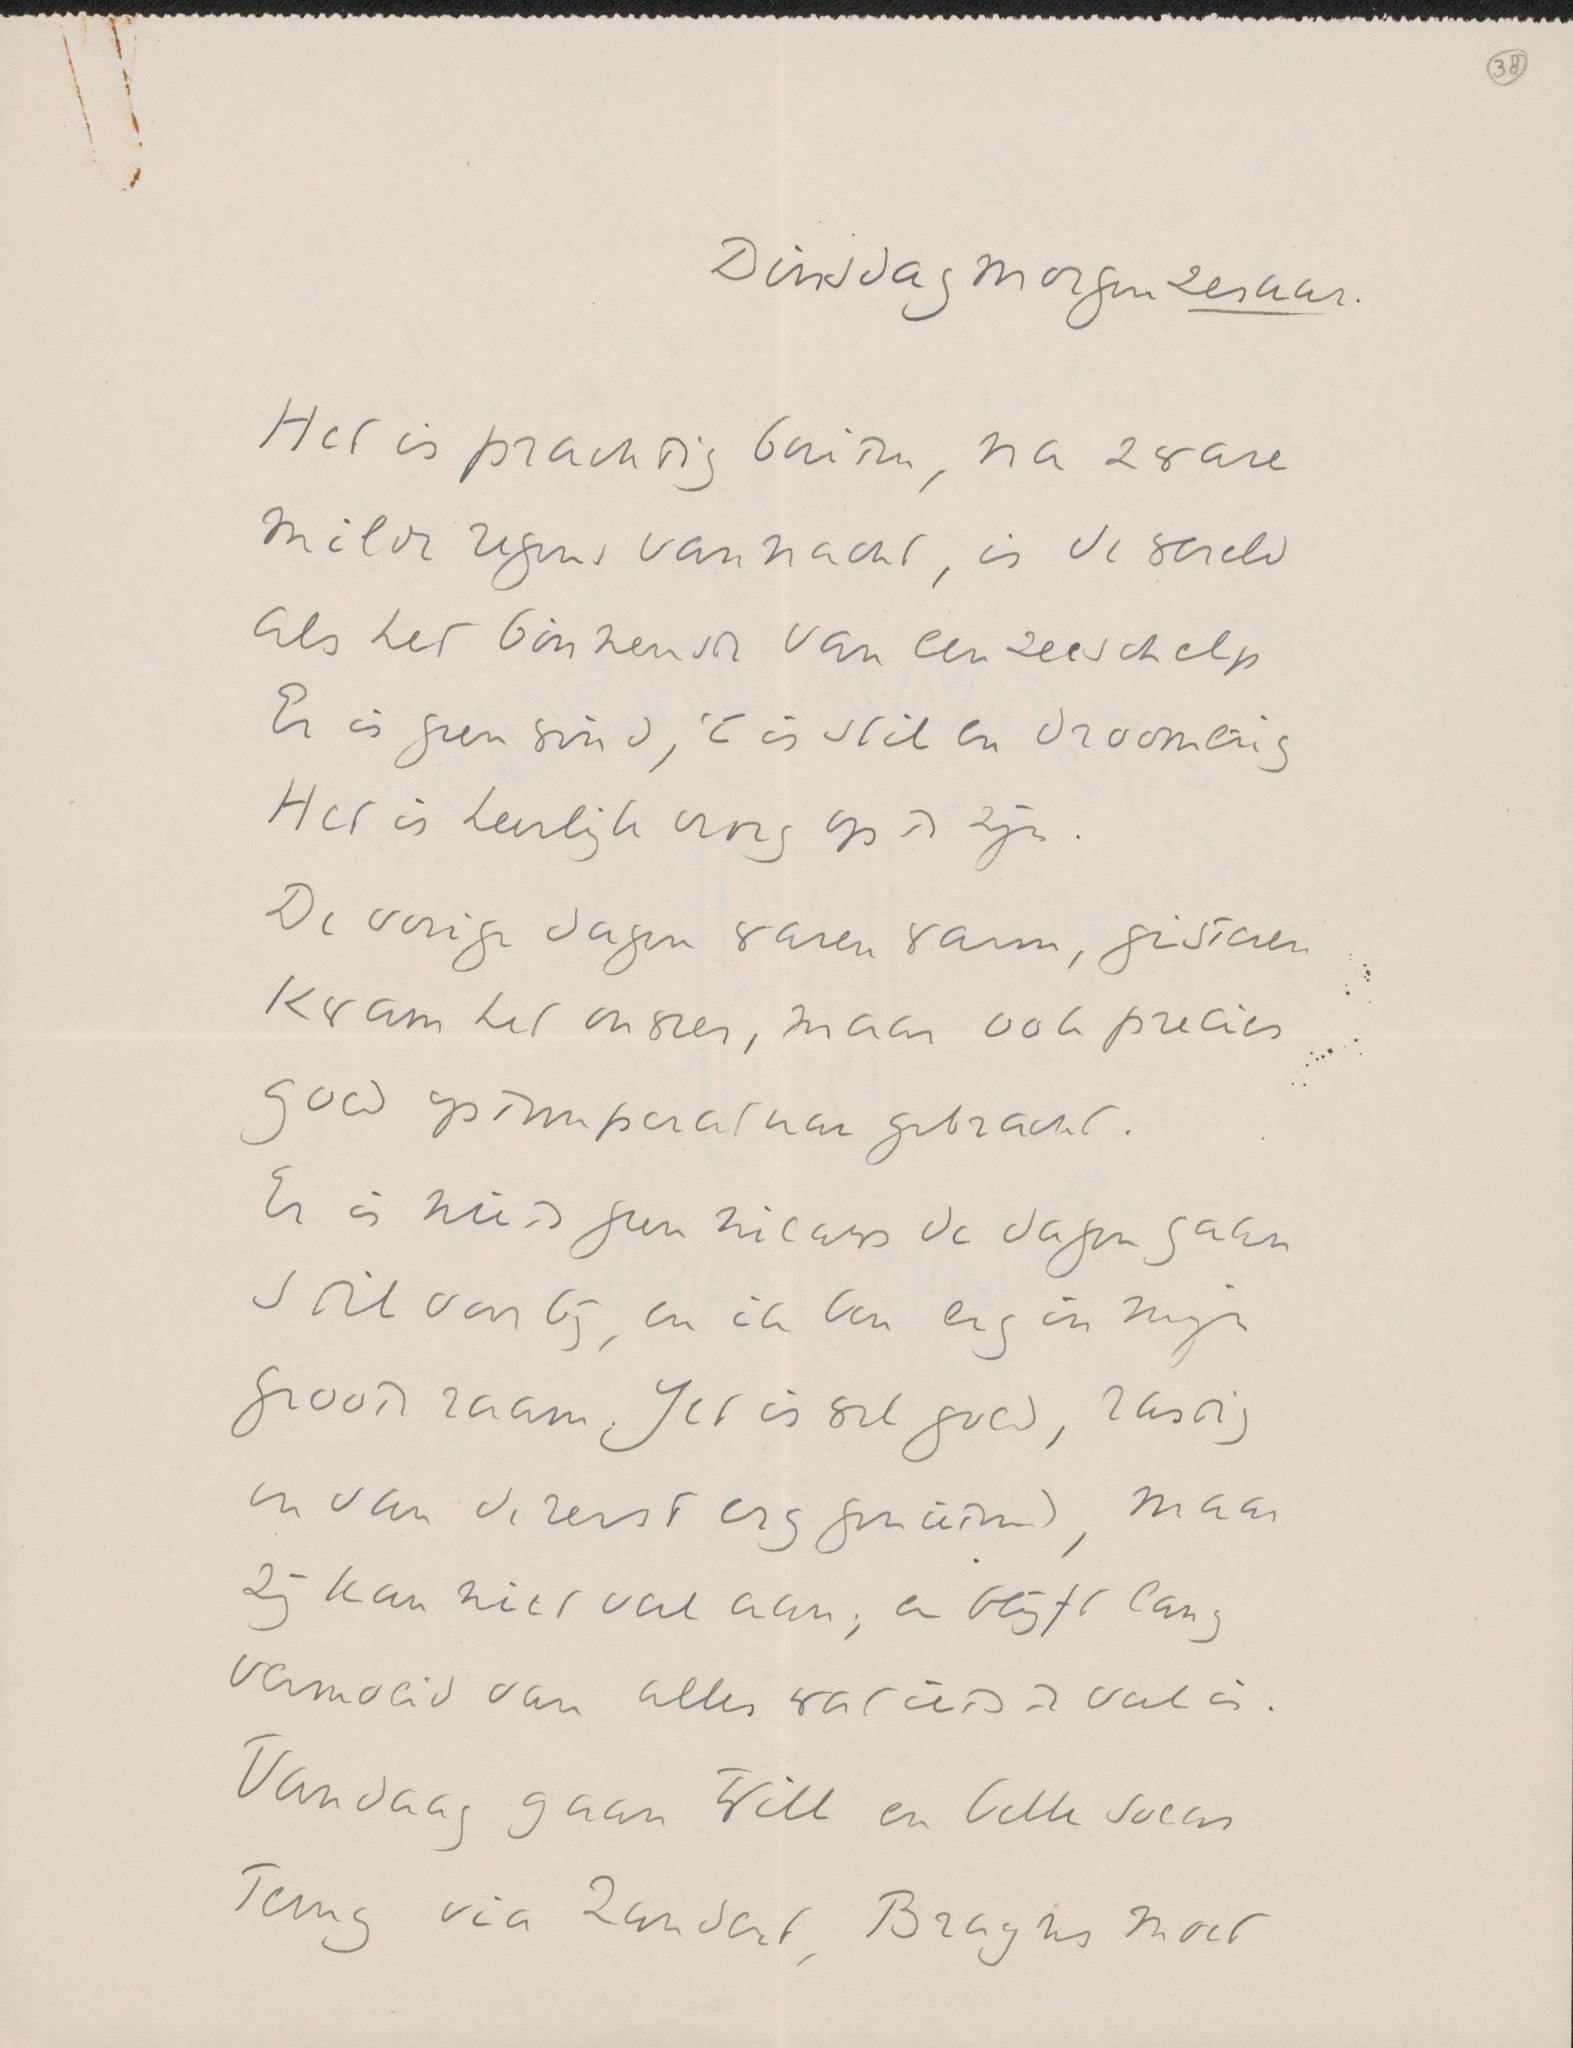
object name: letter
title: Brief aan Ina van Eibergen Santhagens-Waller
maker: richard nicolaüs roland holst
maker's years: 1868-1938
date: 1878-1938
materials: ink, paper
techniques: pen, writing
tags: haarlem, print maker, ina van eibergen santhagens-waller, amsterdam, henriëtte roland holst-van der schalk, applied arts, arts and crafts; industrial design, diseases, paris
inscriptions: collector's mark: ‘RPK’, watermark